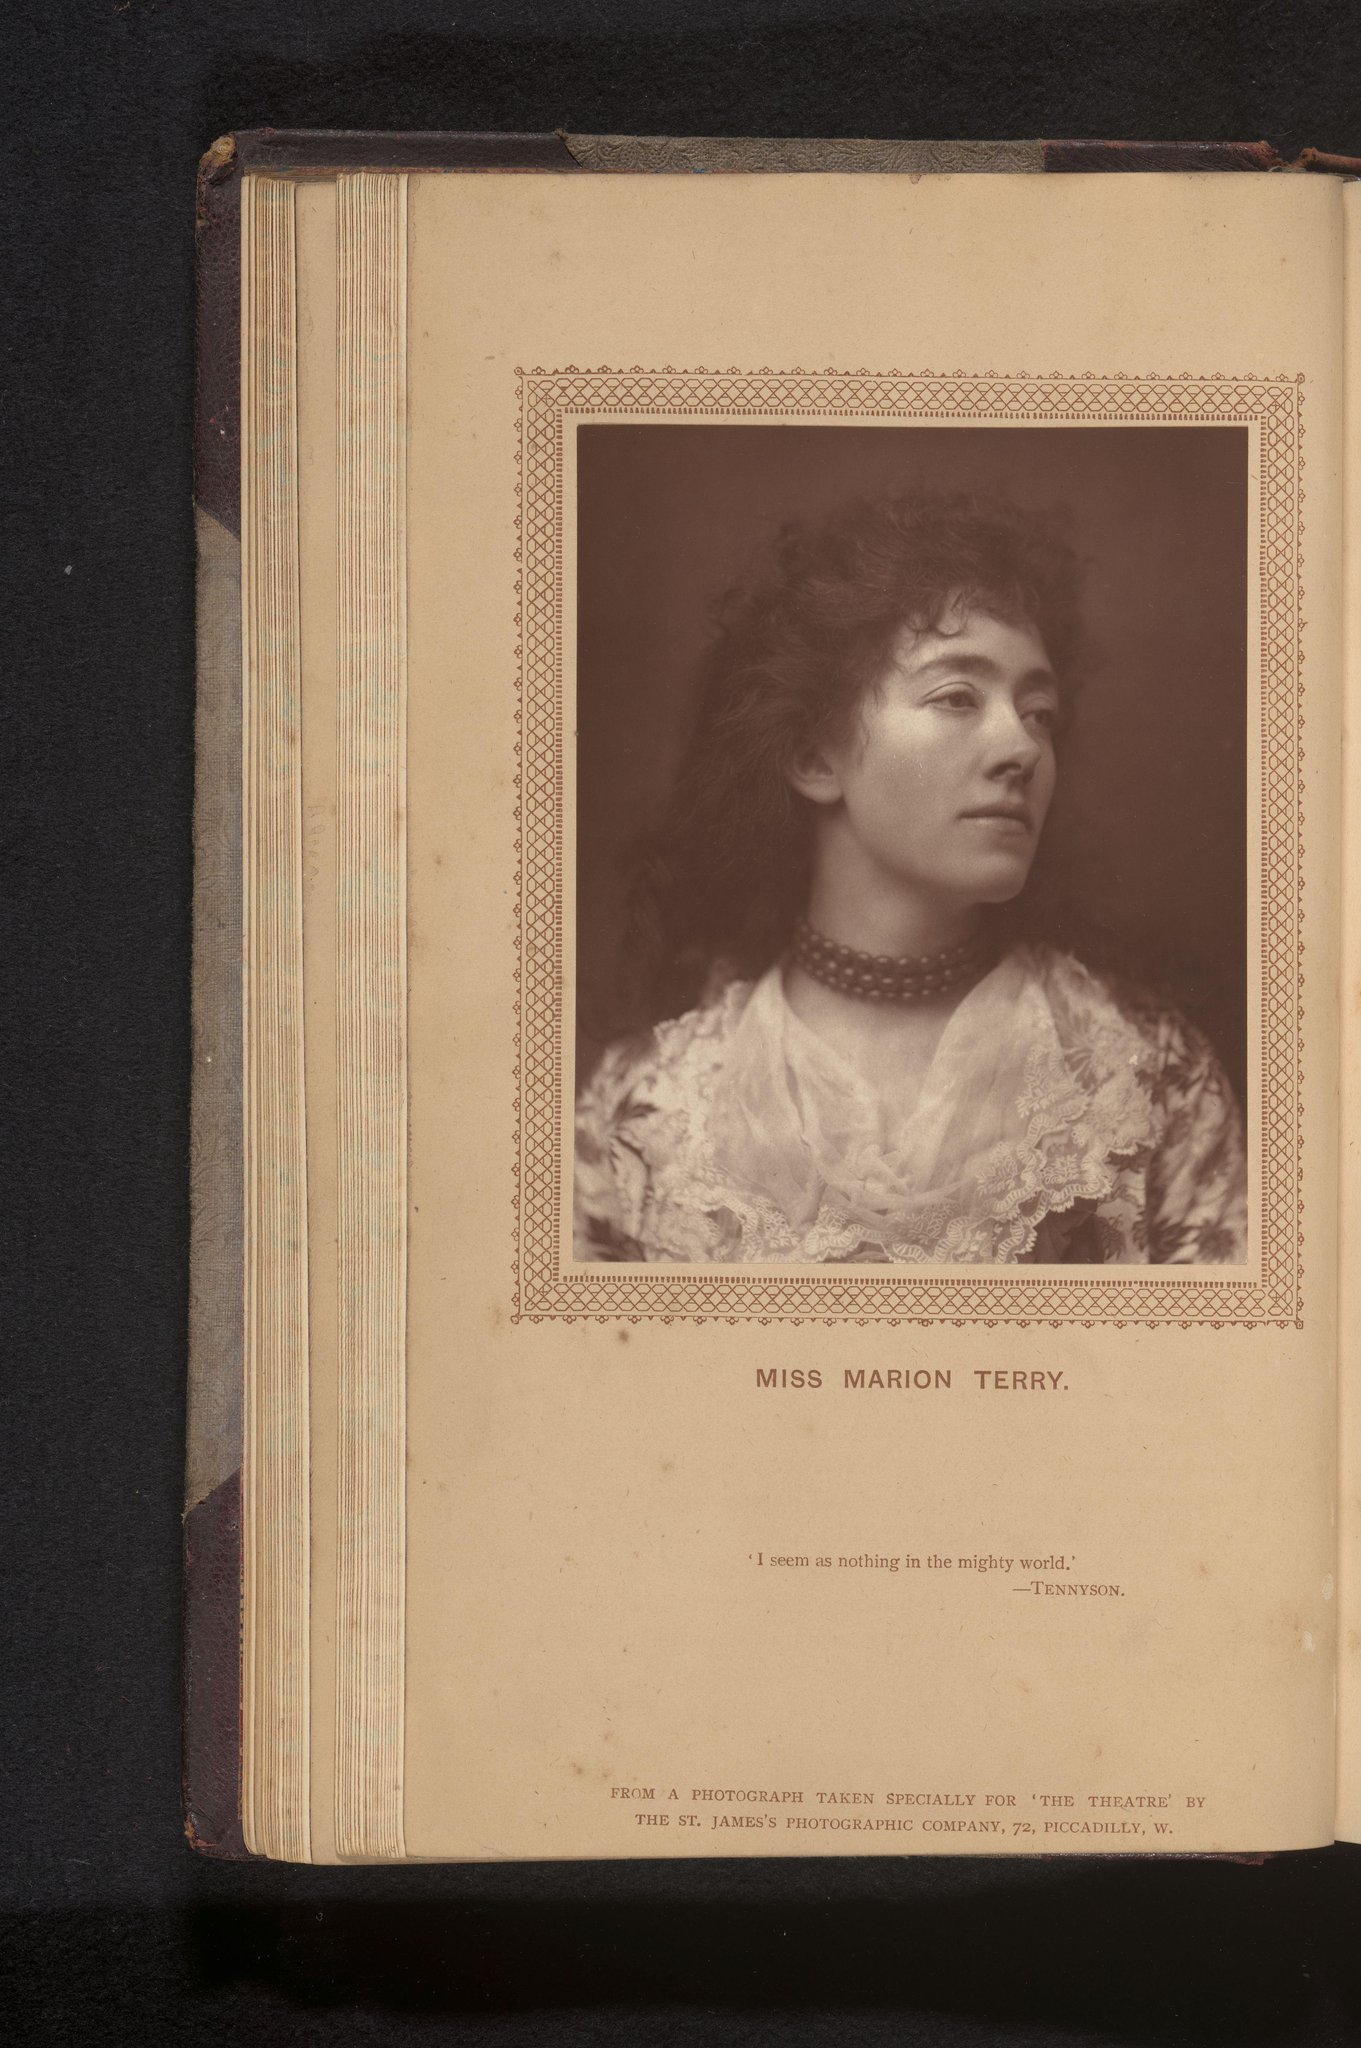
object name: photomechanical print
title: Miss Marion Terry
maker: Anonymous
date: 1878-1883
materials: paper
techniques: woodburytype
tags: adult woman, historical persons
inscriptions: inscription: ‘'I seem as nothing in the mighty world'/ - Tennyson’